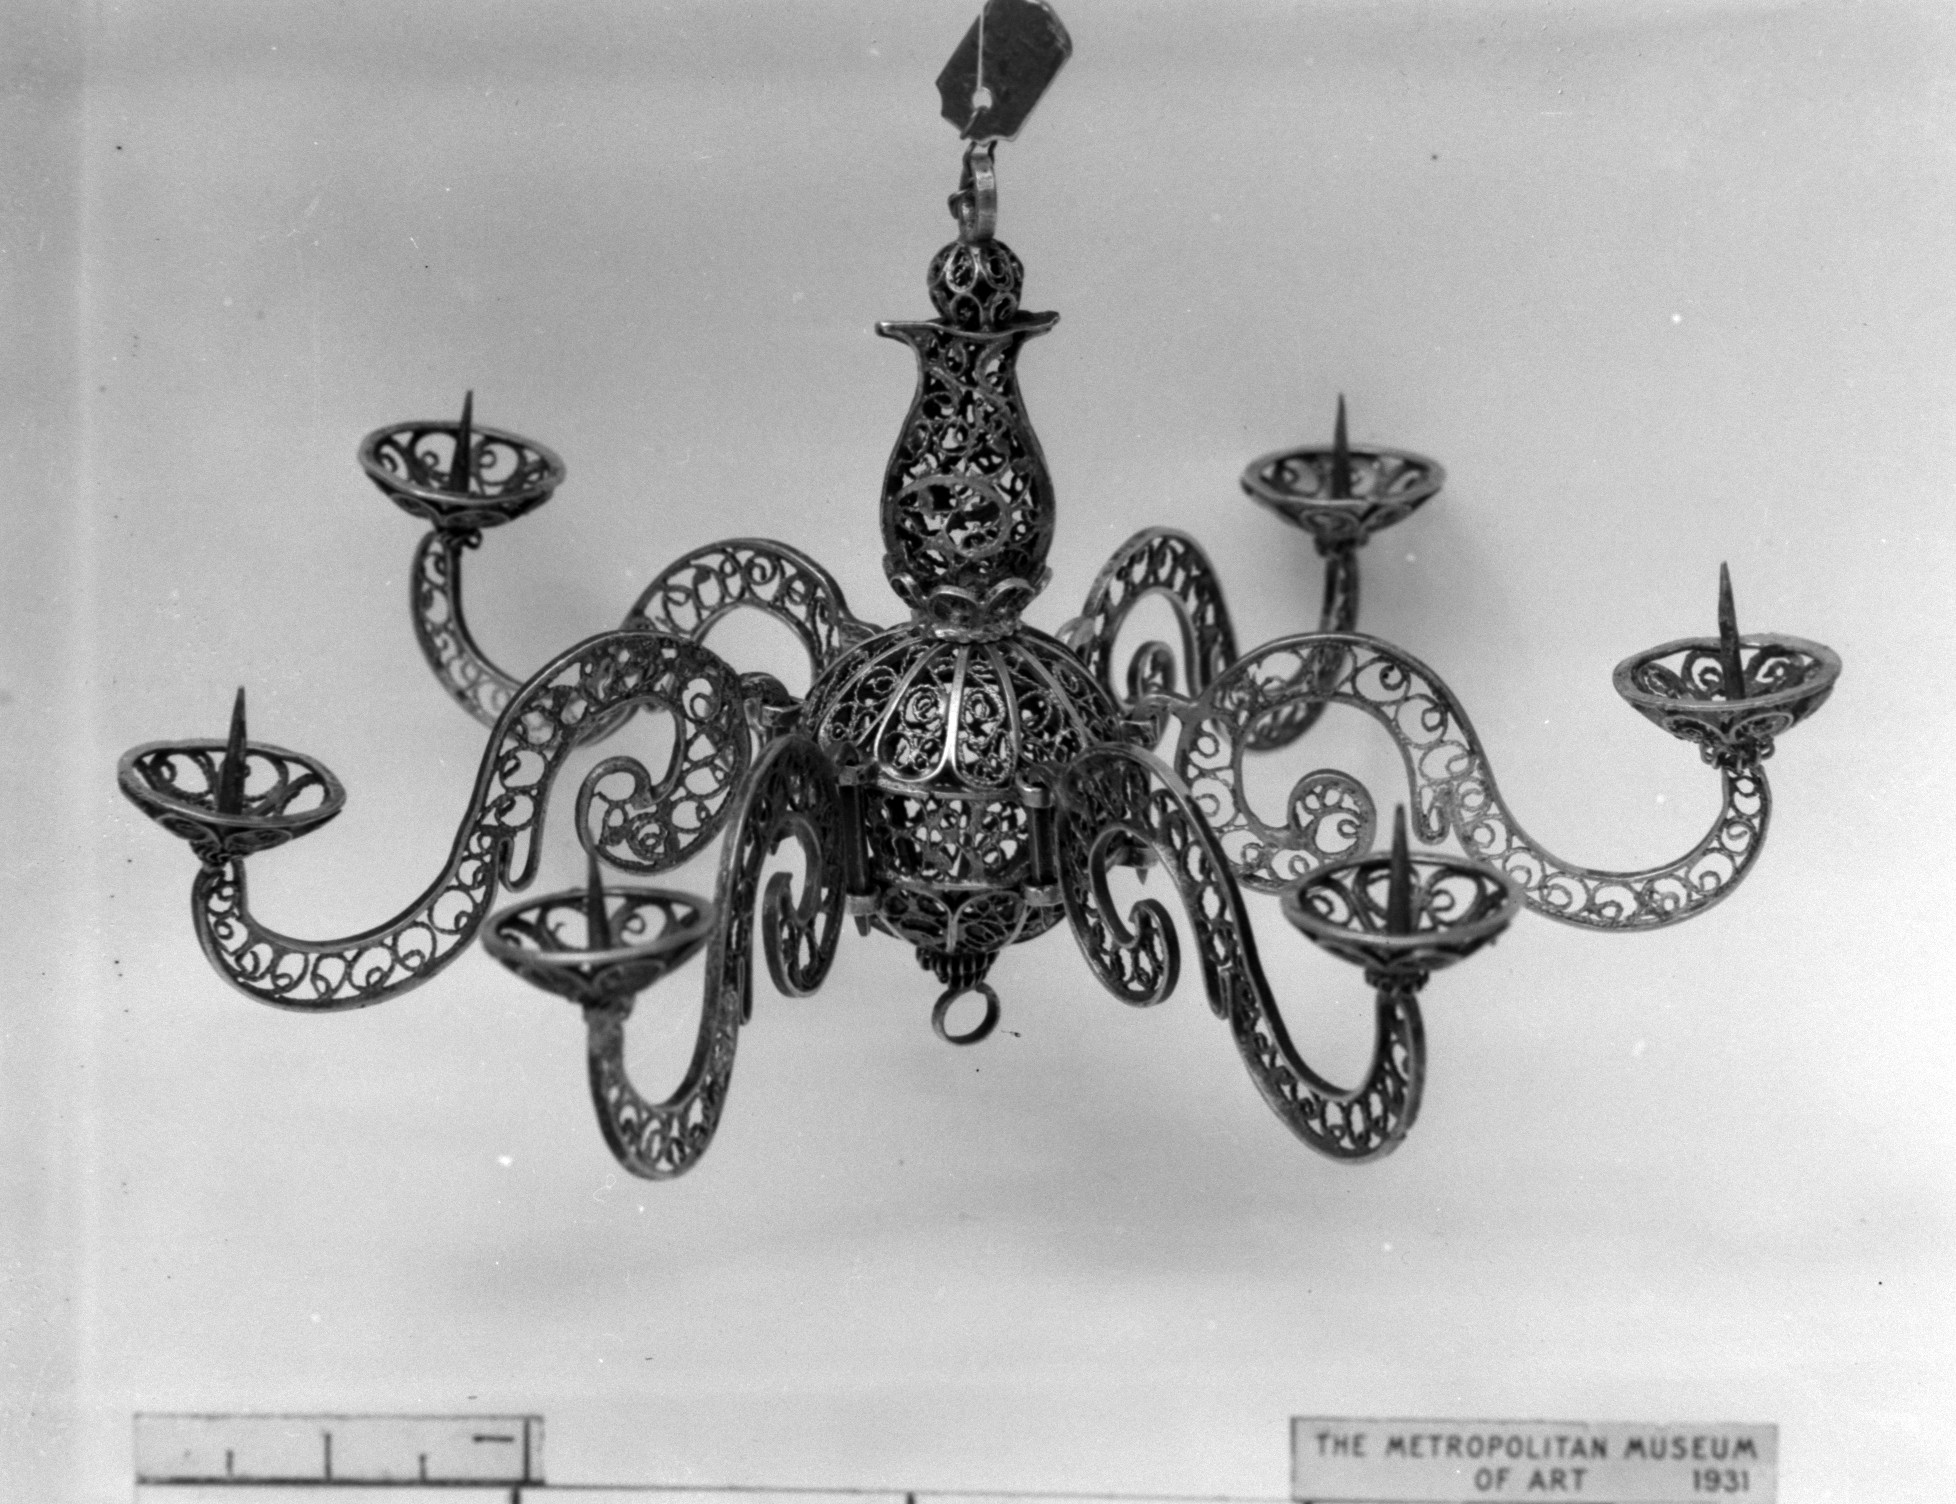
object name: chandelier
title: Miniature chandelier (part of a set)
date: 1675-1700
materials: silver